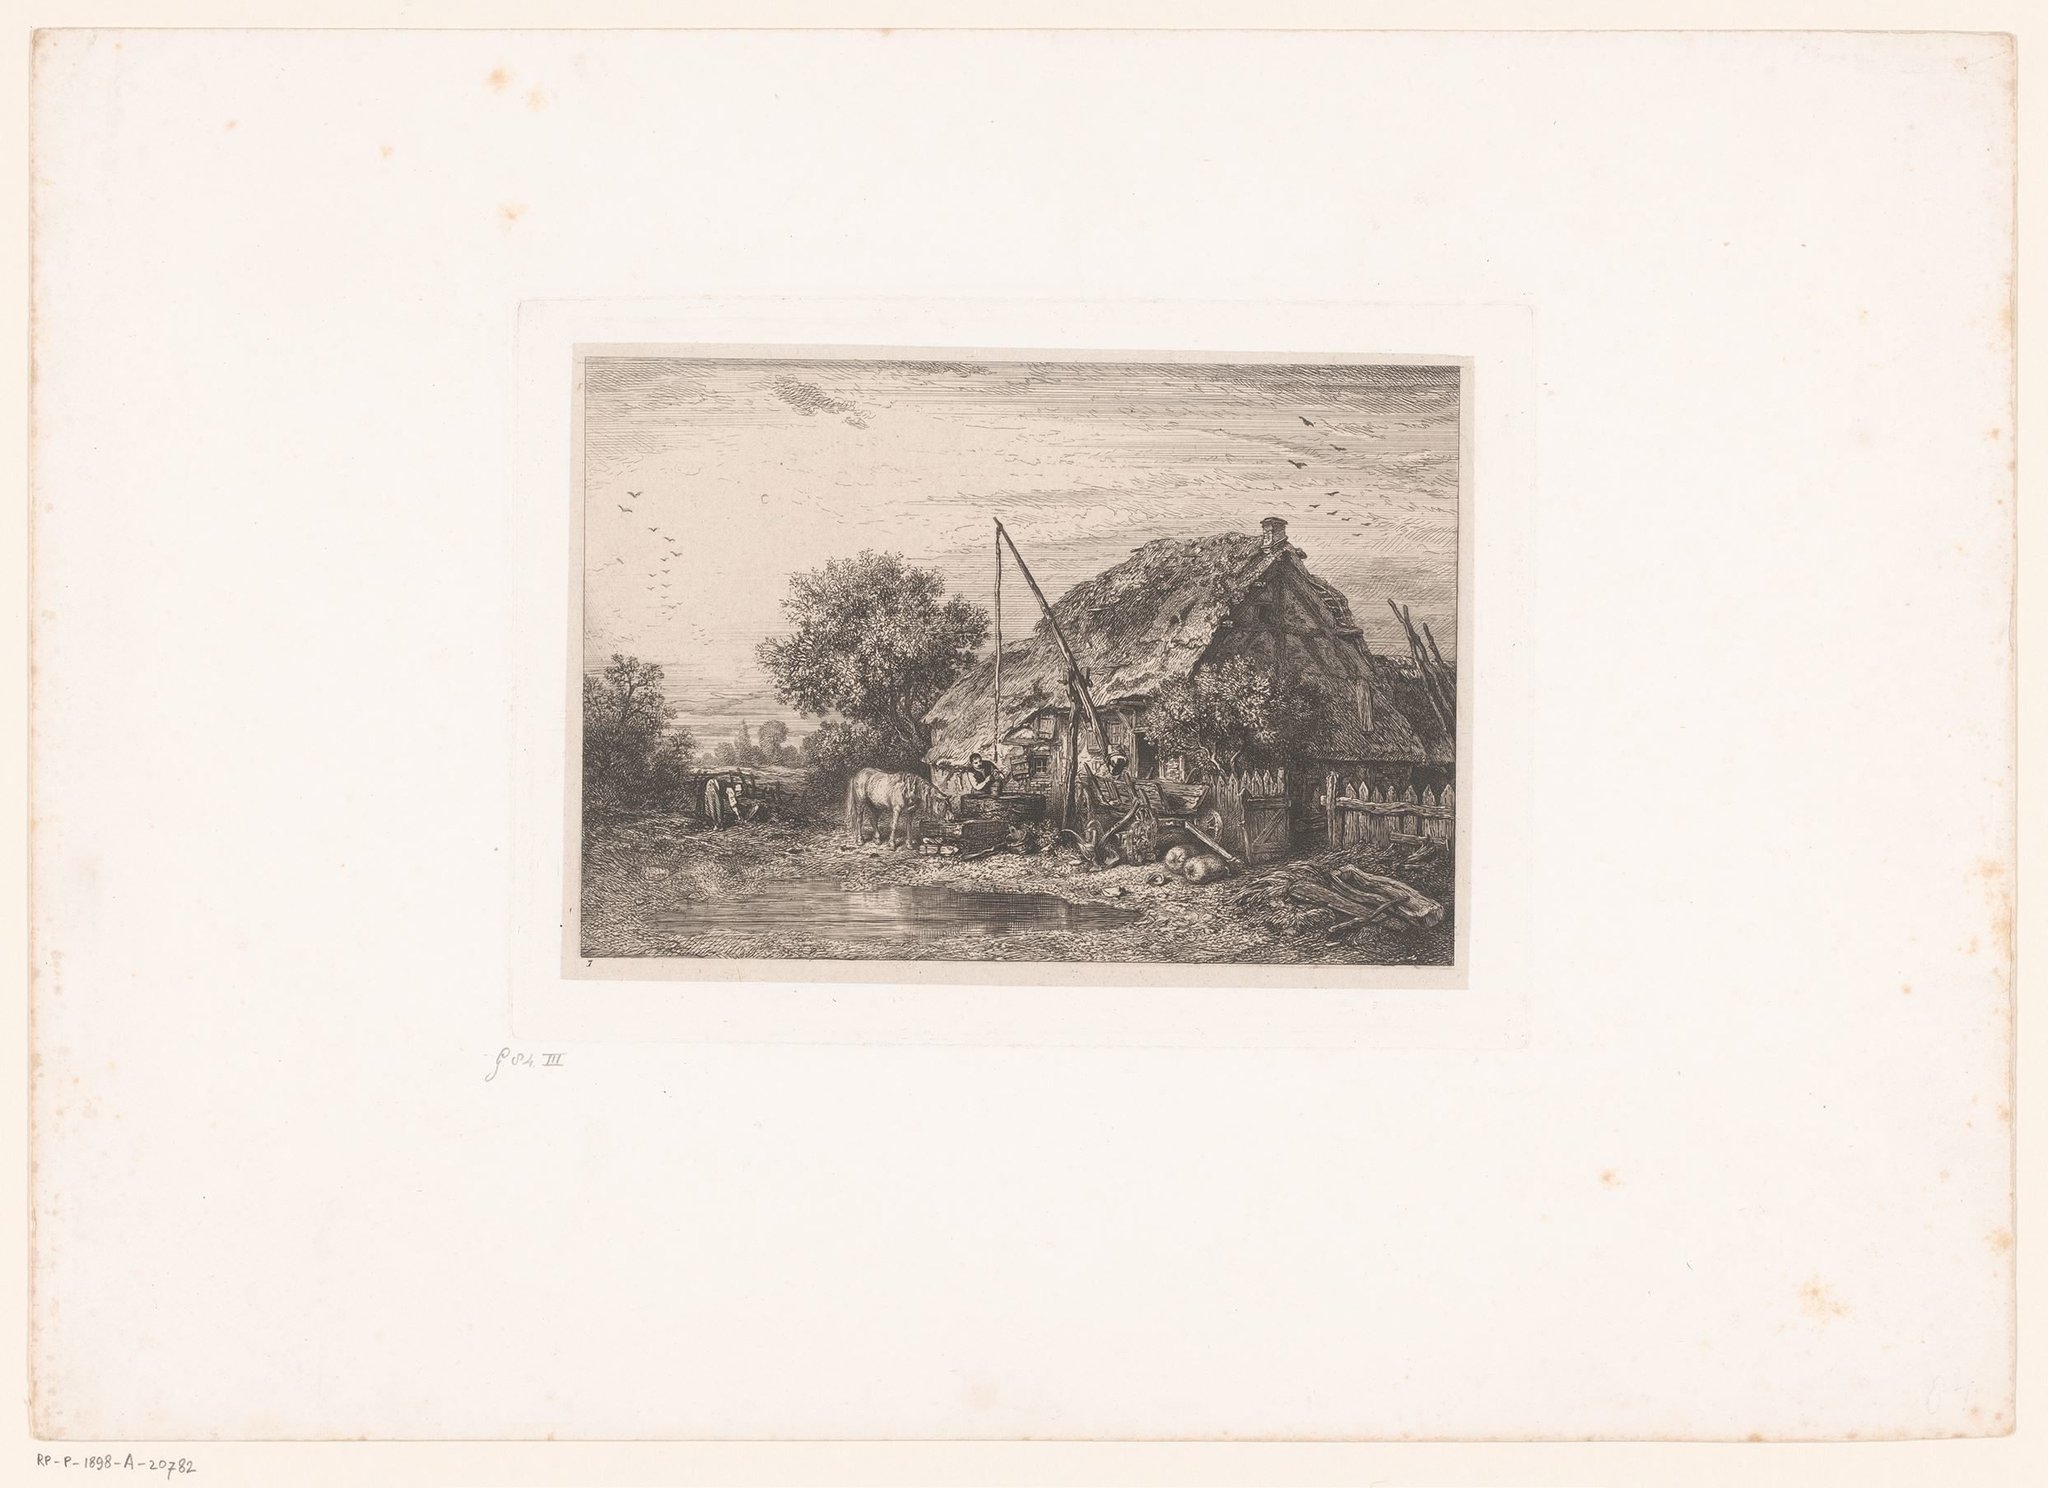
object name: print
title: Verschillende composities door Jacque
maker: charles emile jacque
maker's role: draughtsman, painter, print maker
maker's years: 1813-1894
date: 1845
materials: paper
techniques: drypoint, etching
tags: well, cottage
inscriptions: collector's mark: Lugt 964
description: Maakt deel uit van een twintigdelige serie met verschillende onderwerpen door Jacque.